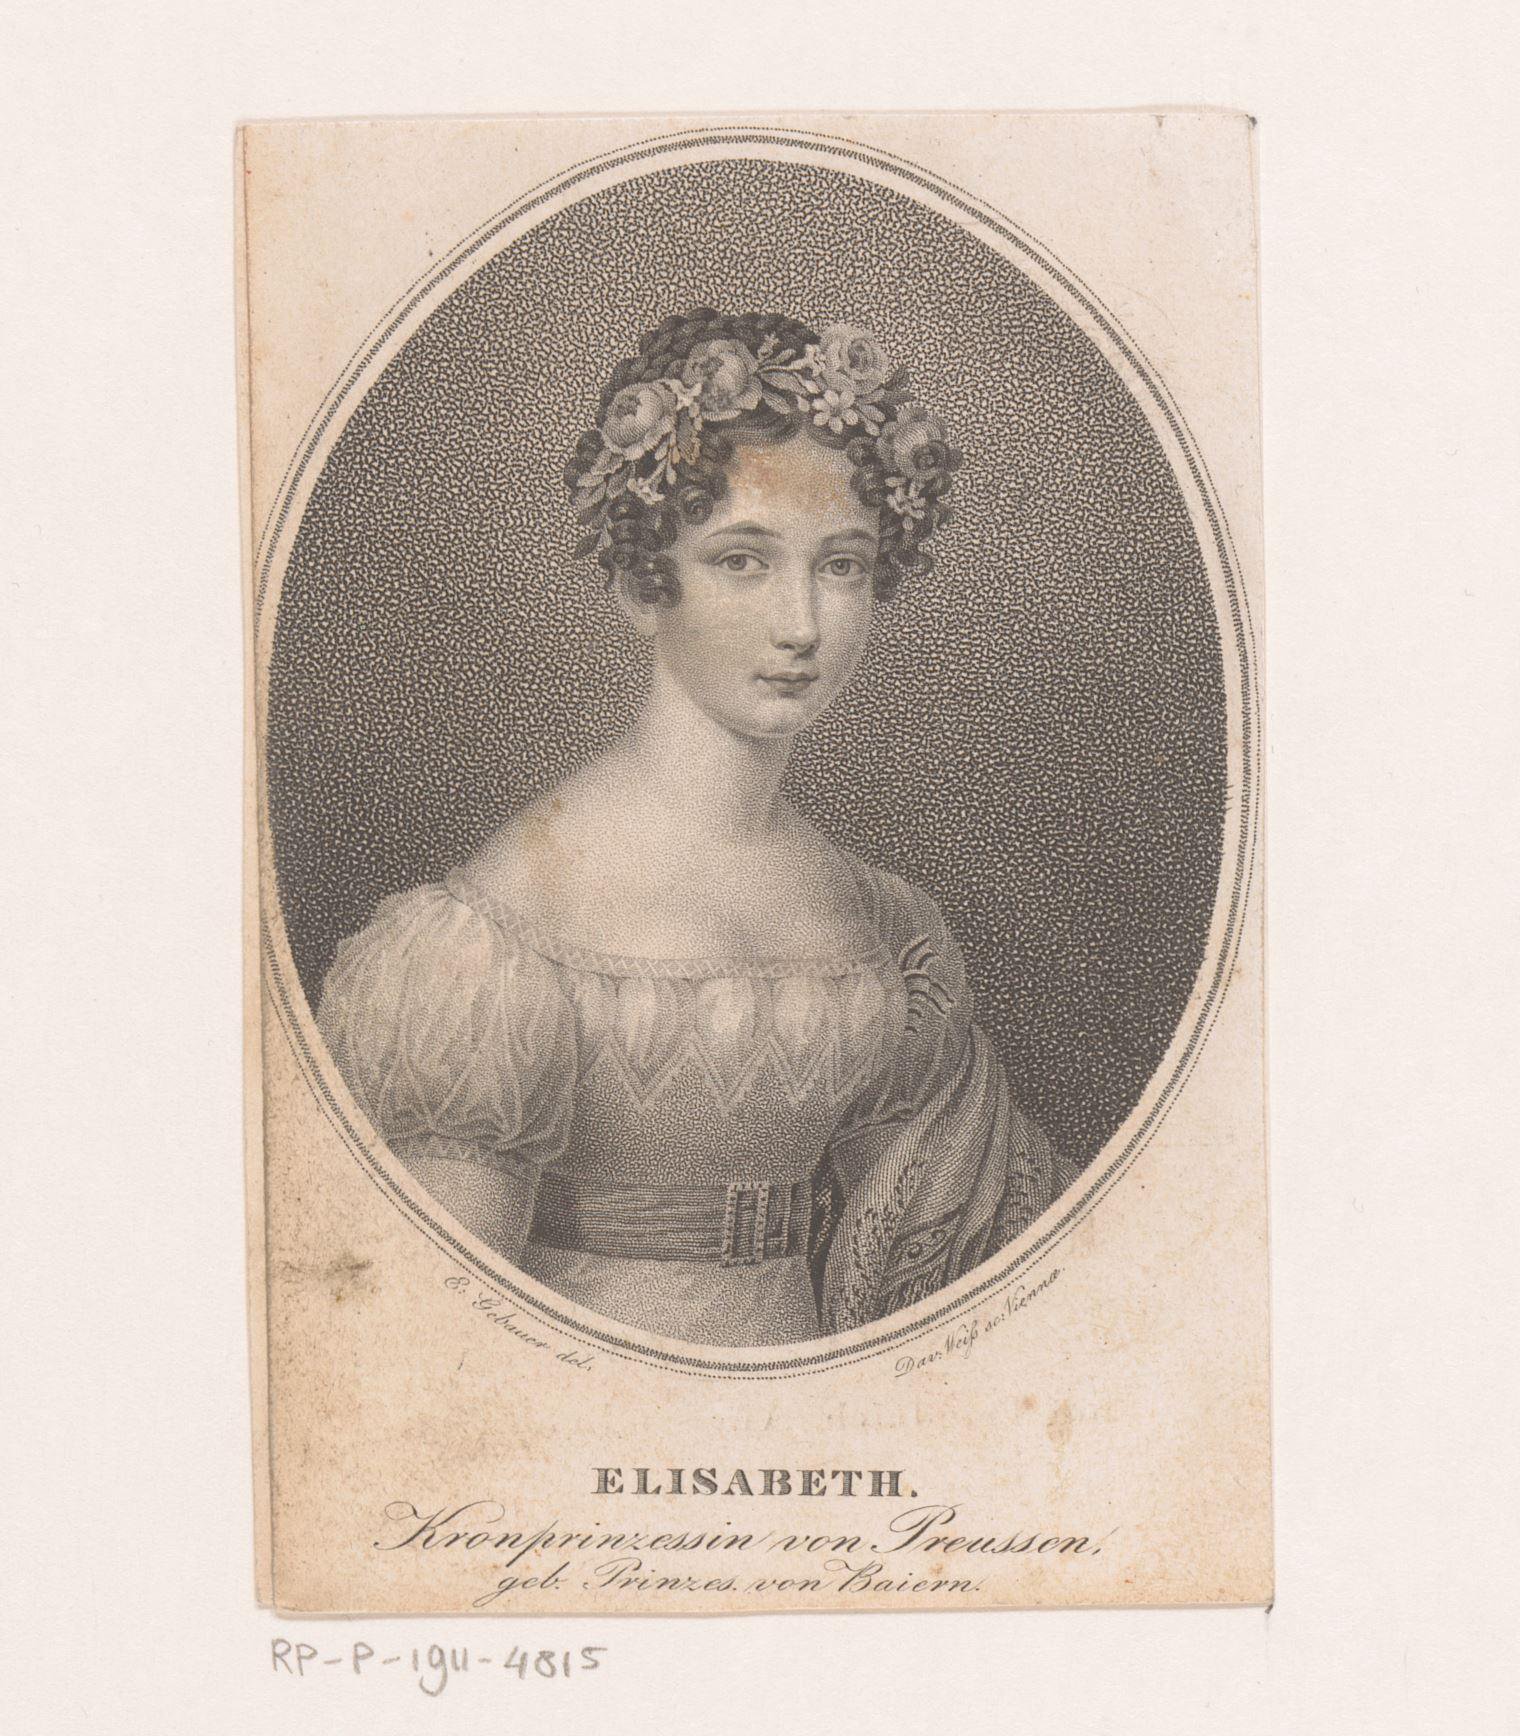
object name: print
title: Portret van Elisabeth Ludovika van Beieren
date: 1815-1840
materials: paper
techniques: engraving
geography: vienna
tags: historical persons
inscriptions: collector's mark: Lugt 2228